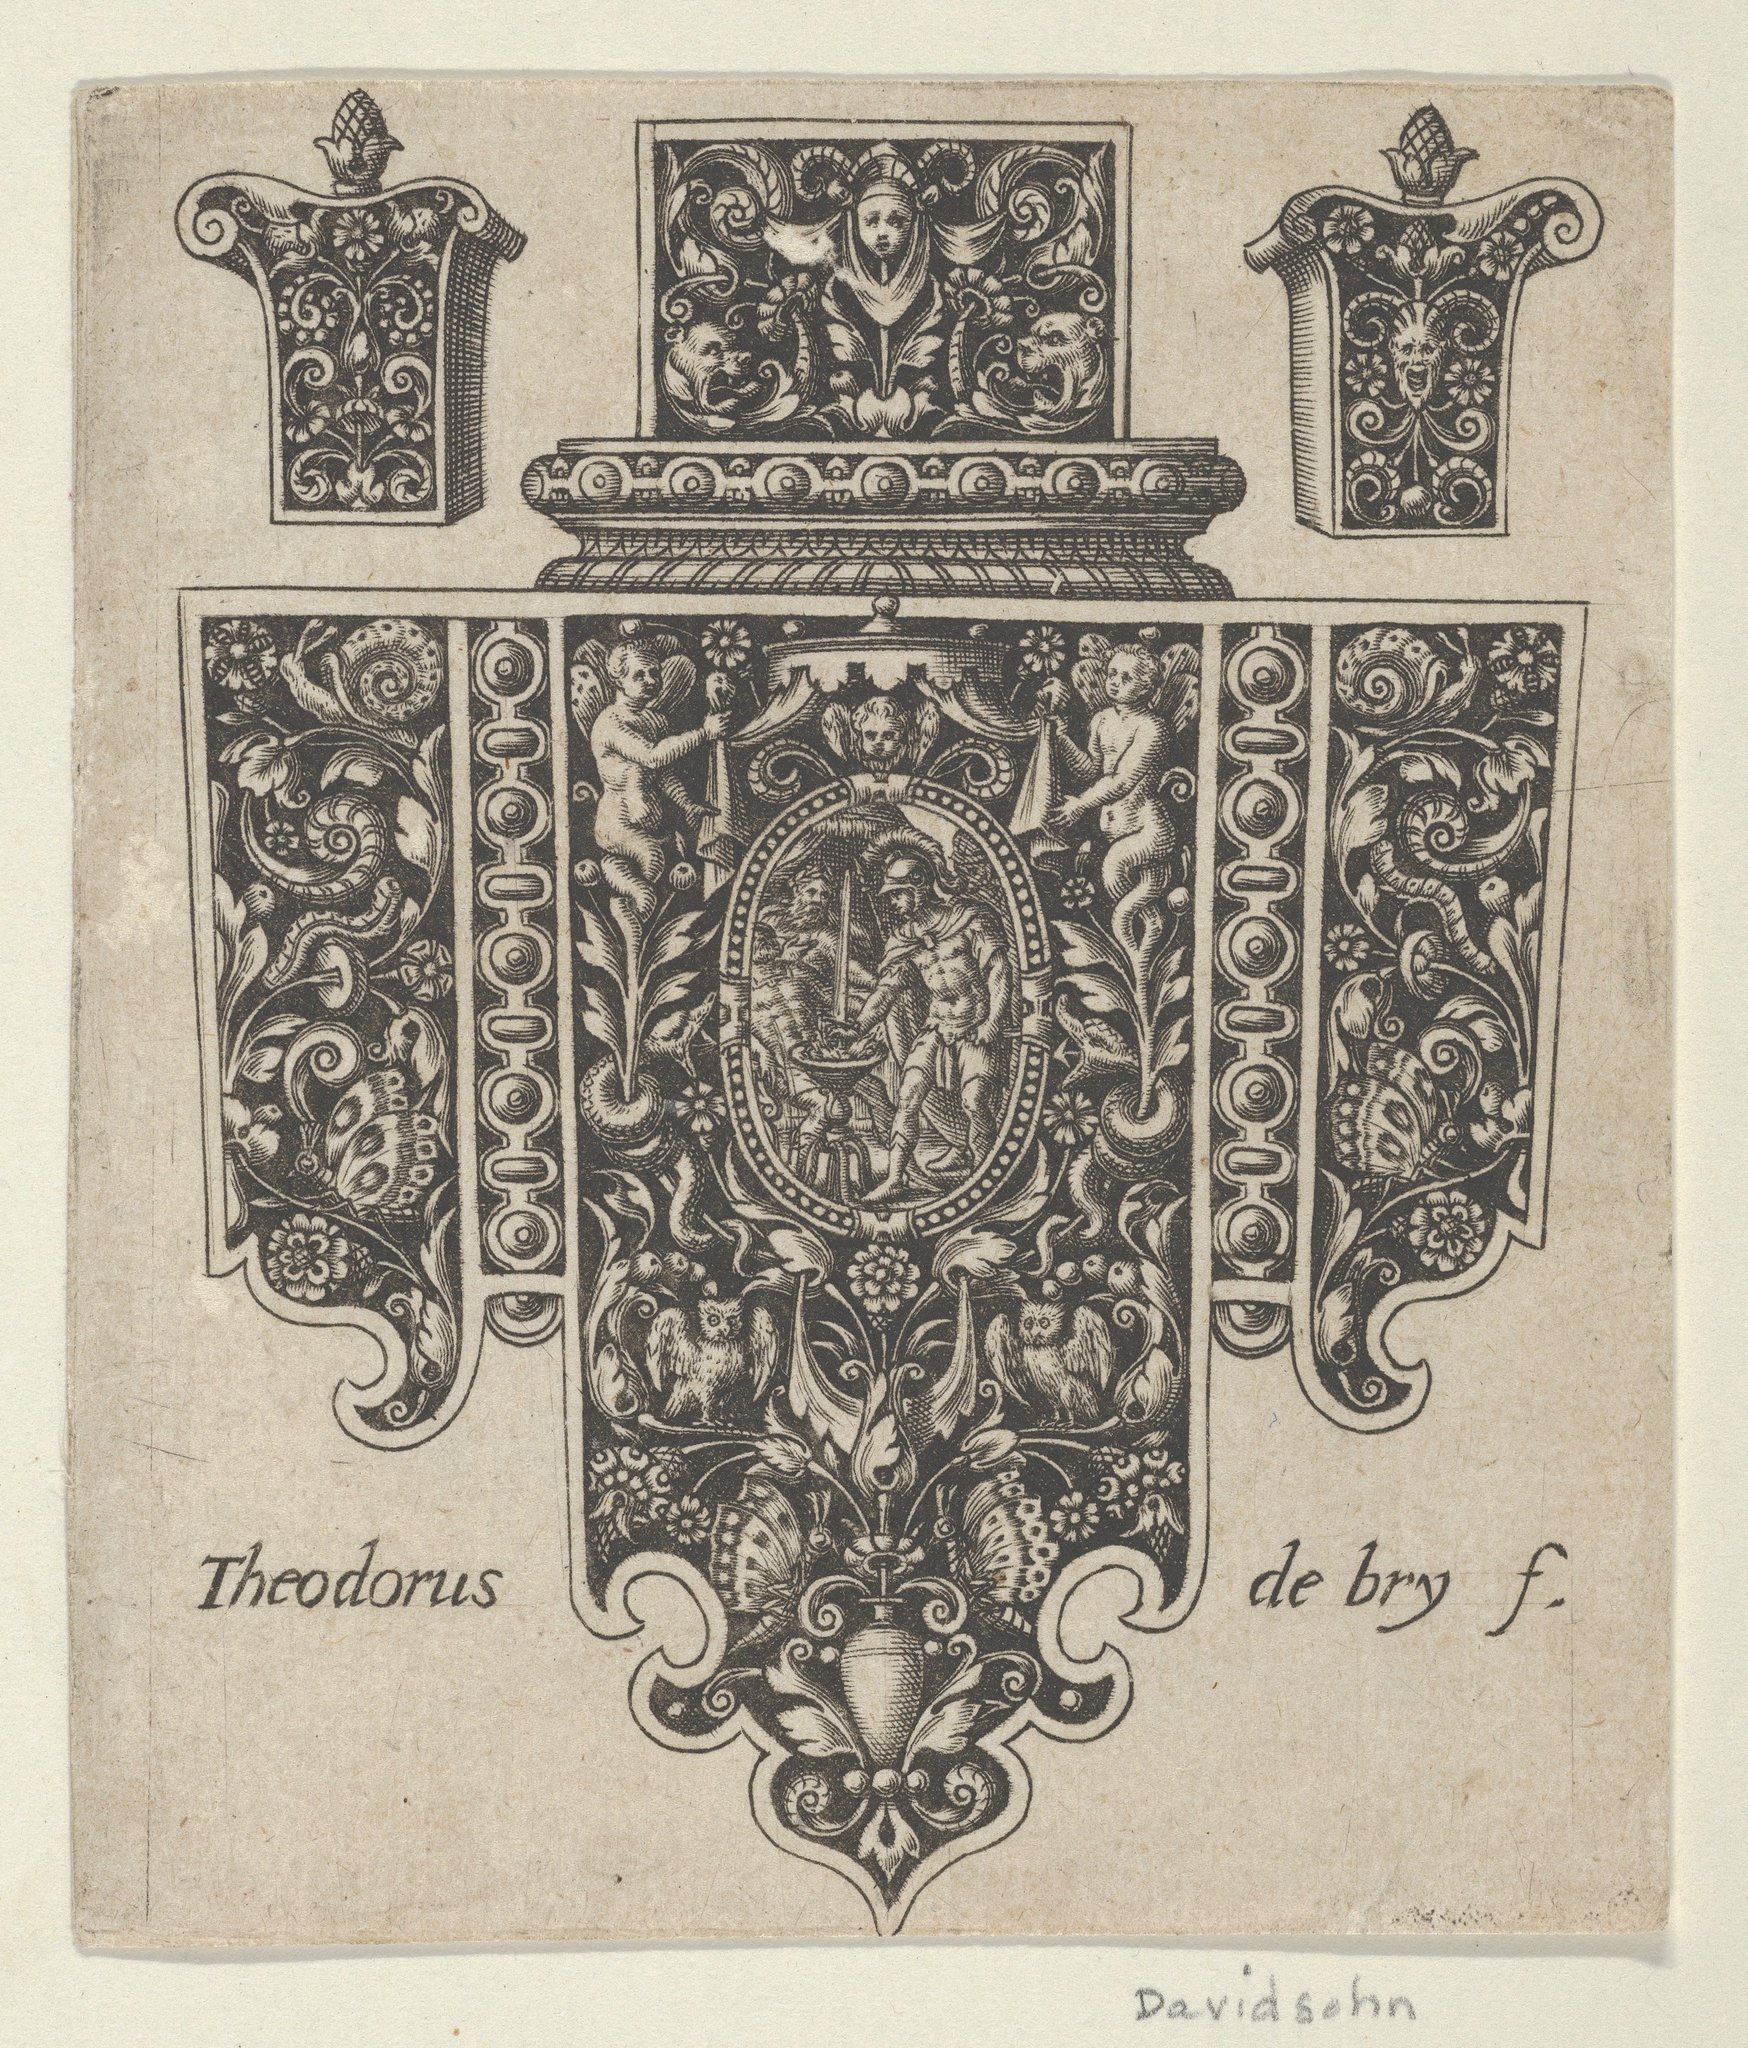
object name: print ornament architecture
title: Design for a Sword or Dagger Handle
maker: theodor de bry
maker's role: artist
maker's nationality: netherlandish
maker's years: 1528-1598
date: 1592-1593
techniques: embroidery, engraving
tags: soldiers,armor,faces